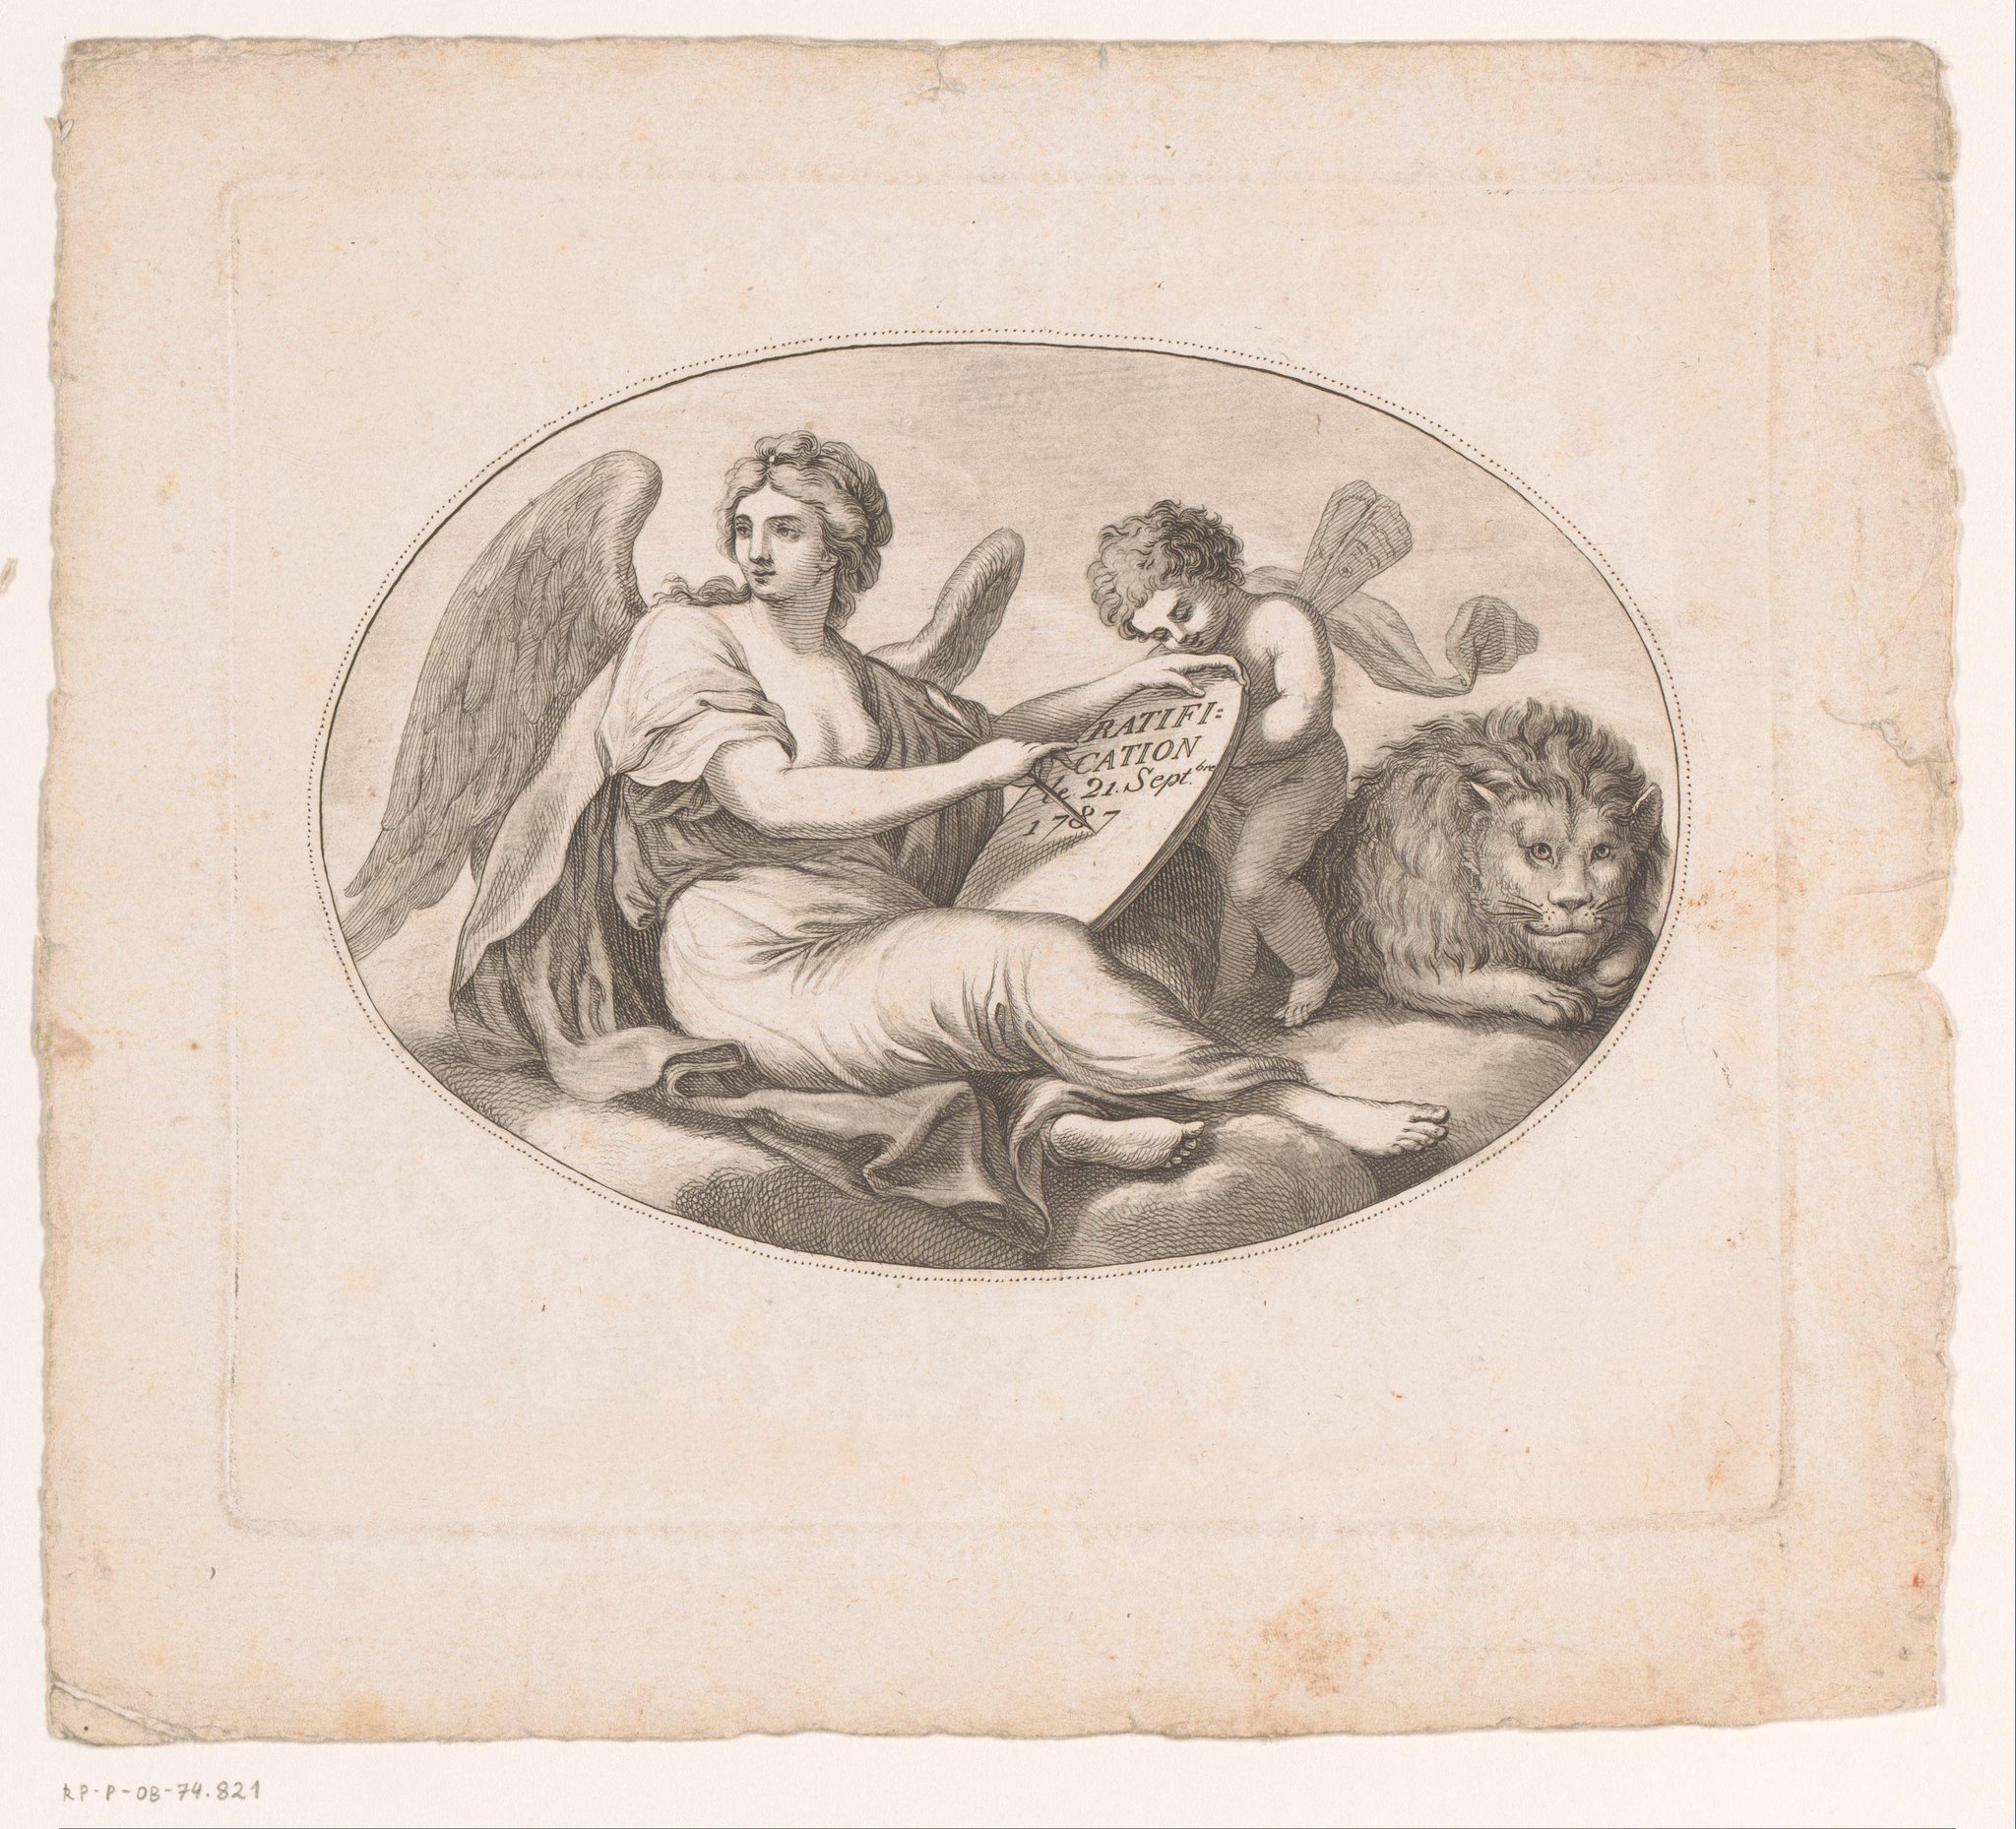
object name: print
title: Gevleugelde vrouw met putto en leeuw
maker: Anonymous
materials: paper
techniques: aquatint, engraving, etching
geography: france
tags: beasts of prey, predatory animals: lion - ff - fabulous animals (sometimes wrongly called 'grotesques'); 'mostri' (ripa), cupids: 'amores', 'amoretti', 'putti'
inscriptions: collector's mark: Lugt 2228